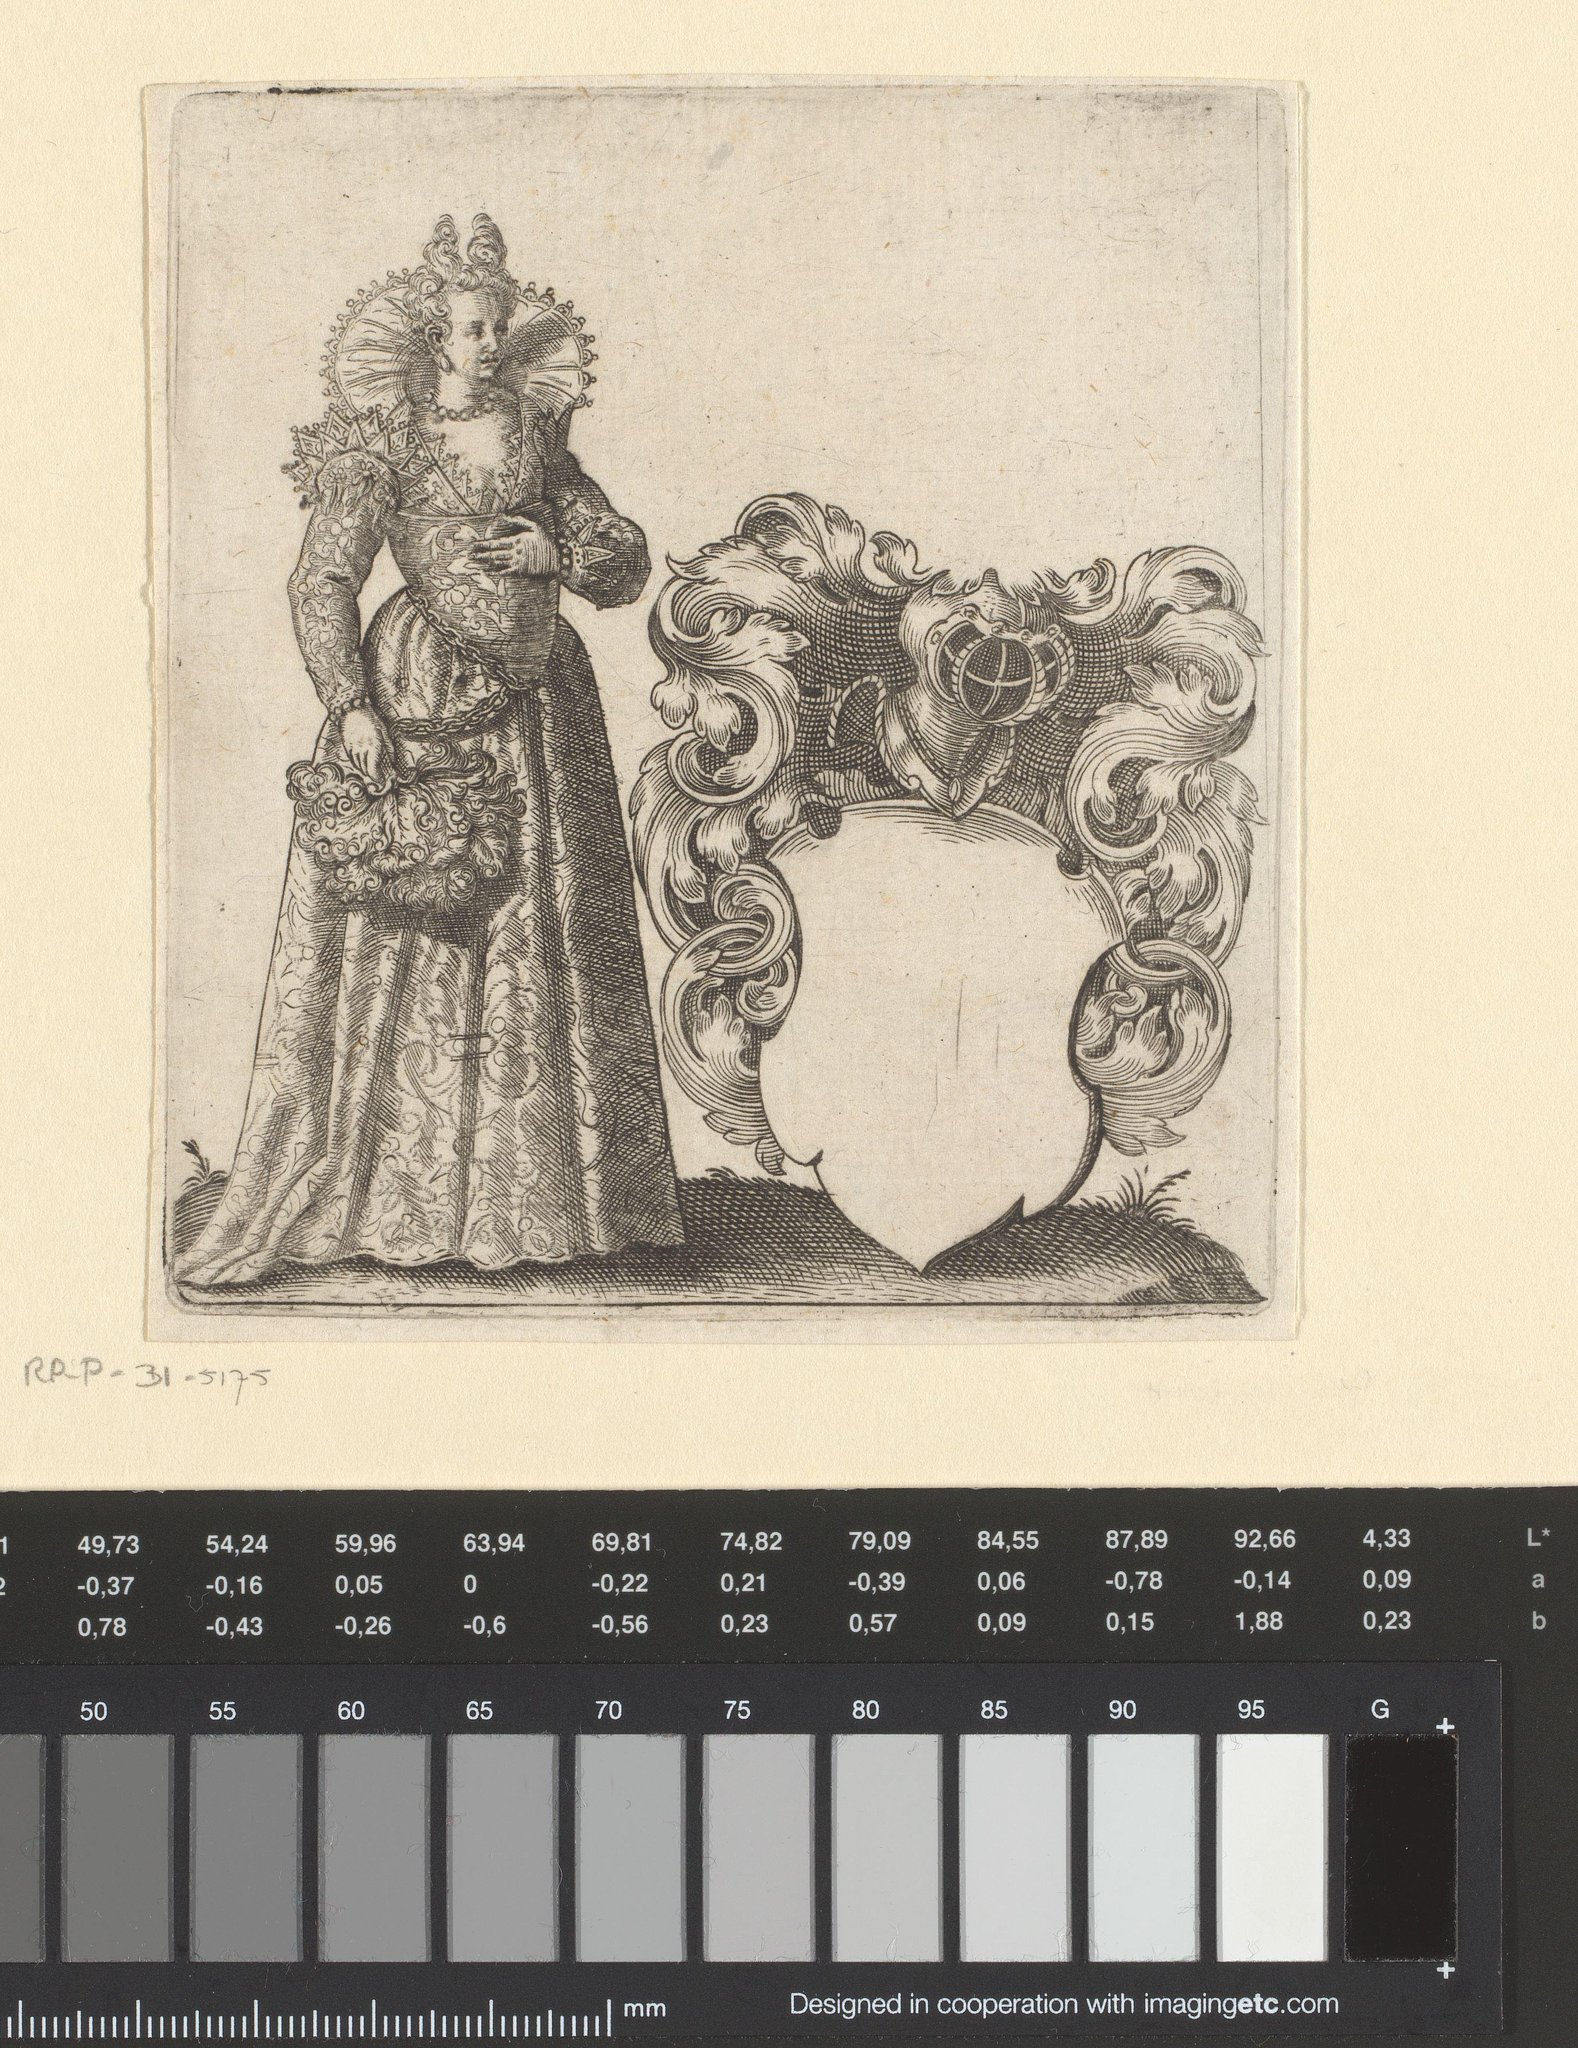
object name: print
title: Emblemata Saecularia, 1596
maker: johann theodor de bry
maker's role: print maker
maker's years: 1561-1623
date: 1596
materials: paper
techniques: engraving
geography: frankfurt am main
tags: armorial bearing, heraldry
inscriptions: collector's mark: Lugt 240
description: Afkomstig uit: Emblemata Saecularia. Mira et iucunda varietate seculi huius mores ita experimentia (...). 1e druk. Frankfurt am Main: J.T. de Bry en J.I. de Bry, 1596.